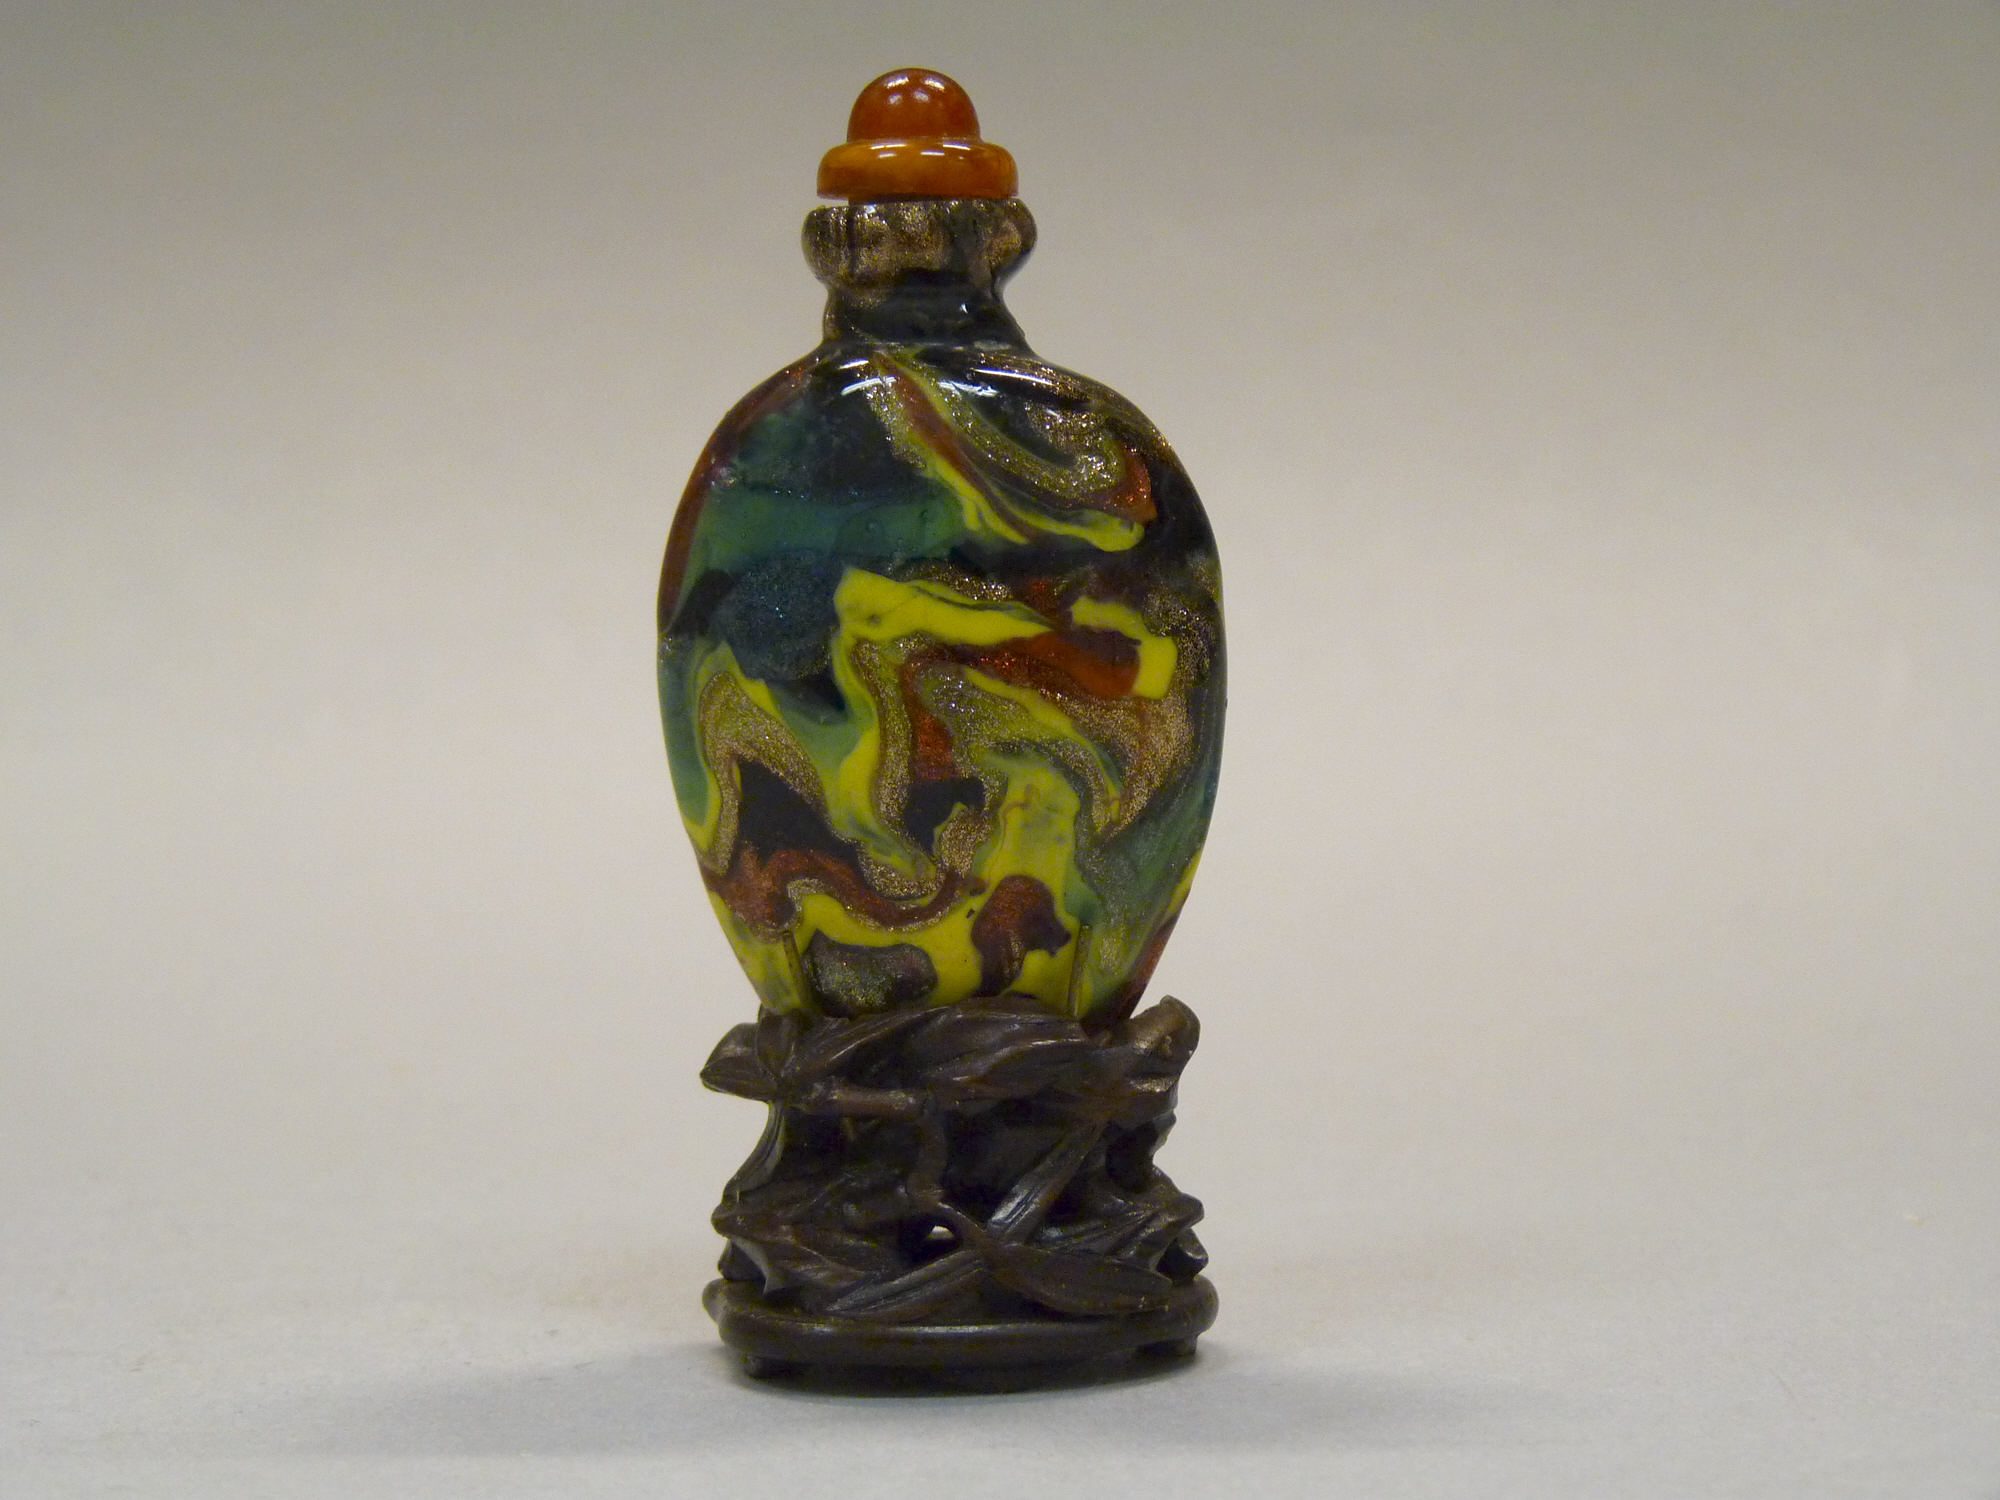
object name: snuff bottle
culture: chinese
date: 1801-1900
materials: amber, glass, wood